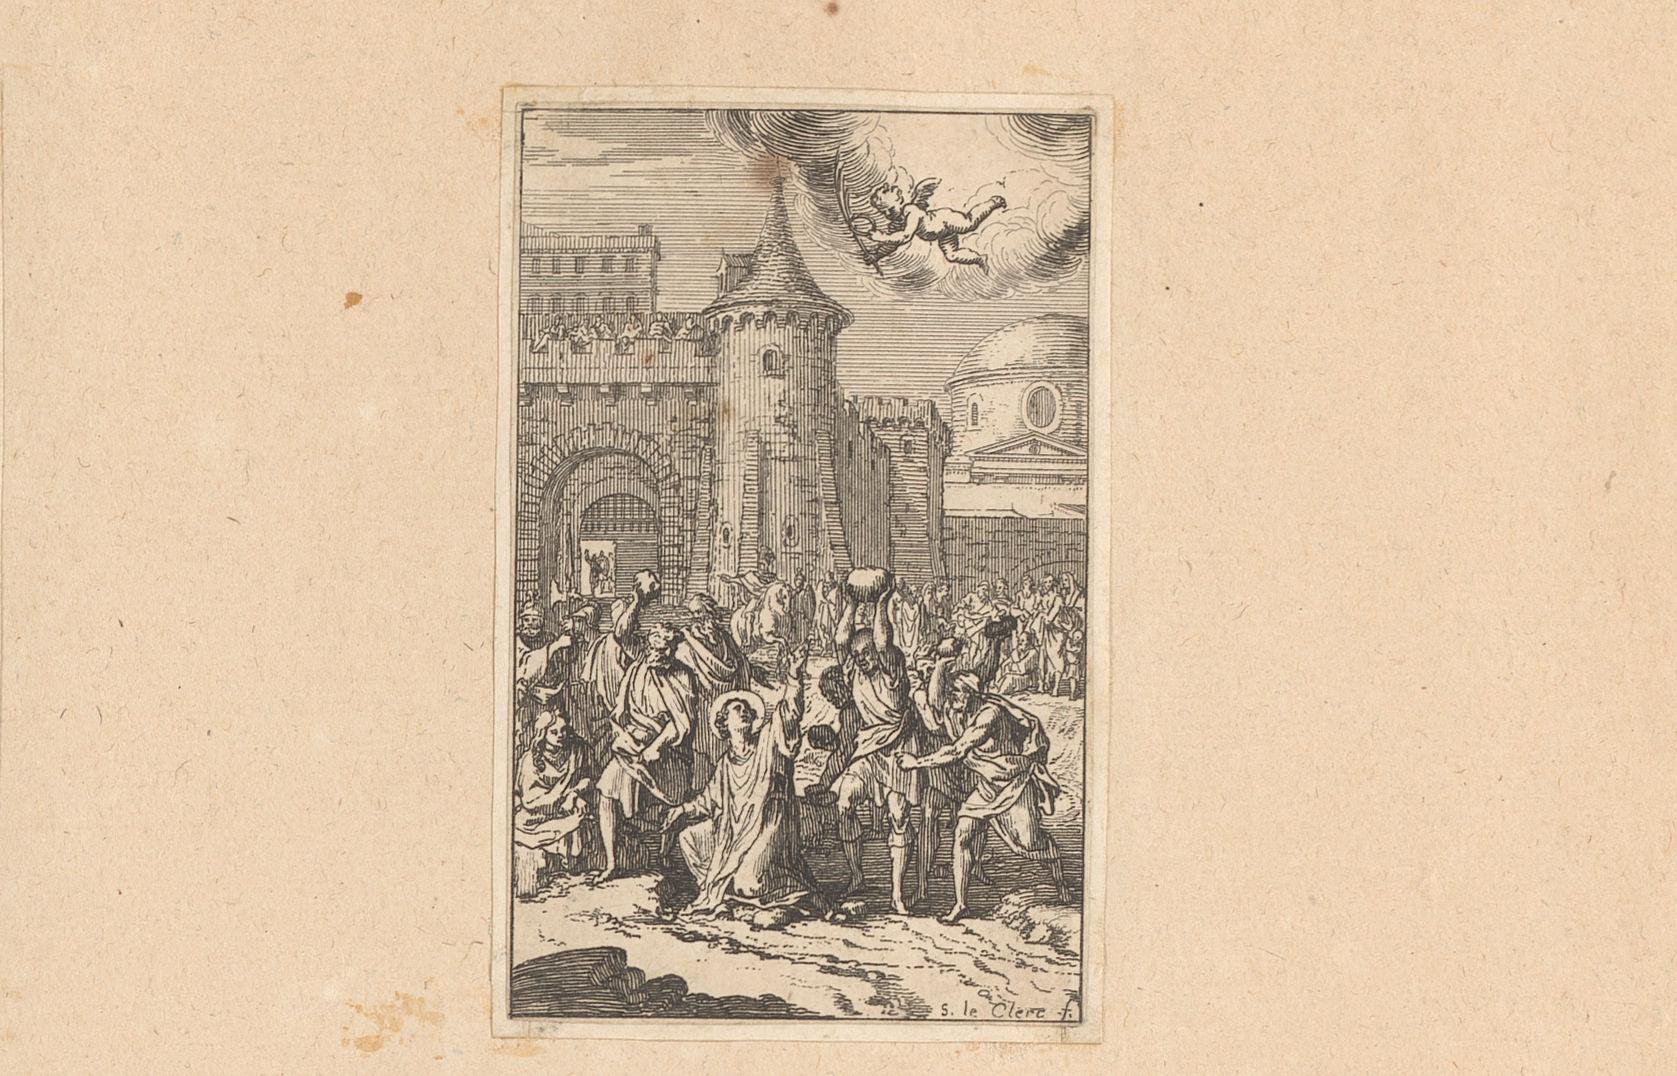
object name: album leaf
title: Martelaarschap van H. Stefanus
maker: sébastien leclerc (i)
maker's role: print maker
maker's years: 1637-1714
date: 1647-1680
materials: paper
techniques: etching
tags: the stoning of stephen; the witnesses lay down their clothes at saul's feet